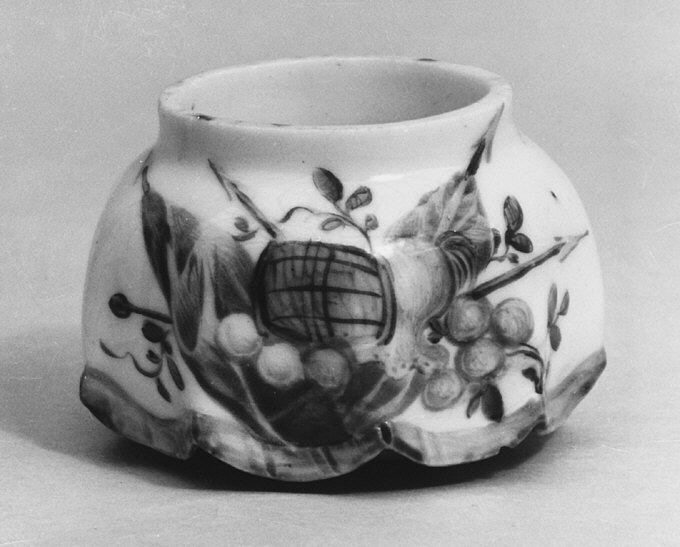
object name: snuffbox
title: Snuffbox (?) (one of a pair)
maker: mennecy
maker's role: factory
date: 1760-1770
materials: soft paste porcelain